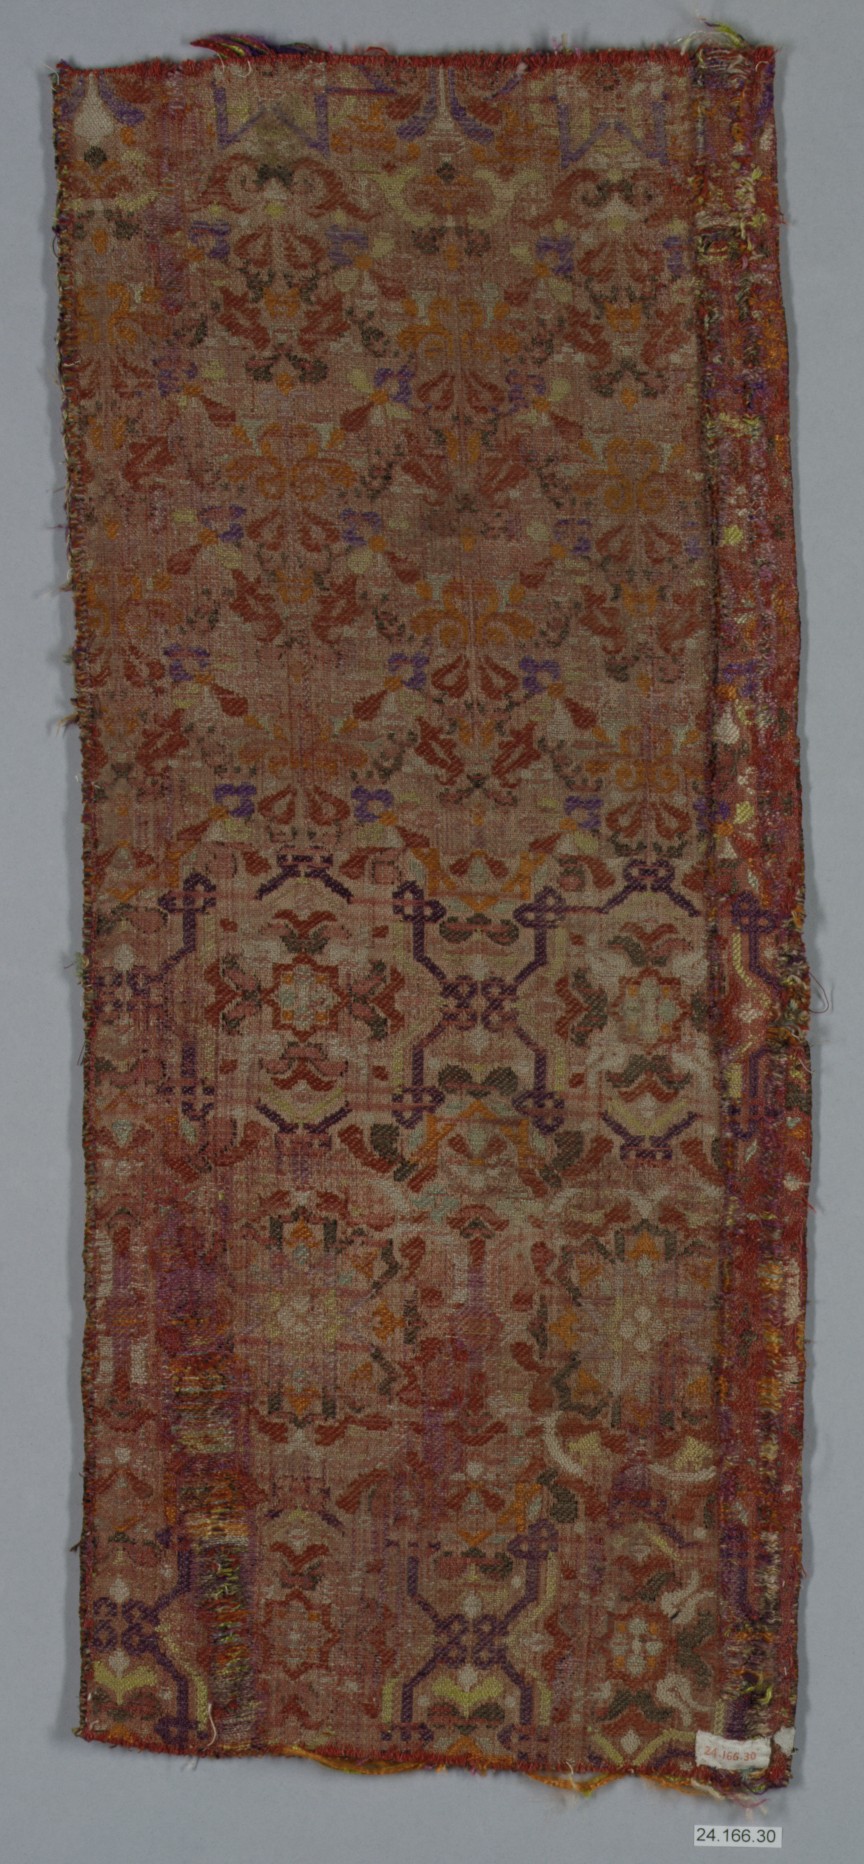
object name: piece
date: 1601-1633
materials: metal thread, silk